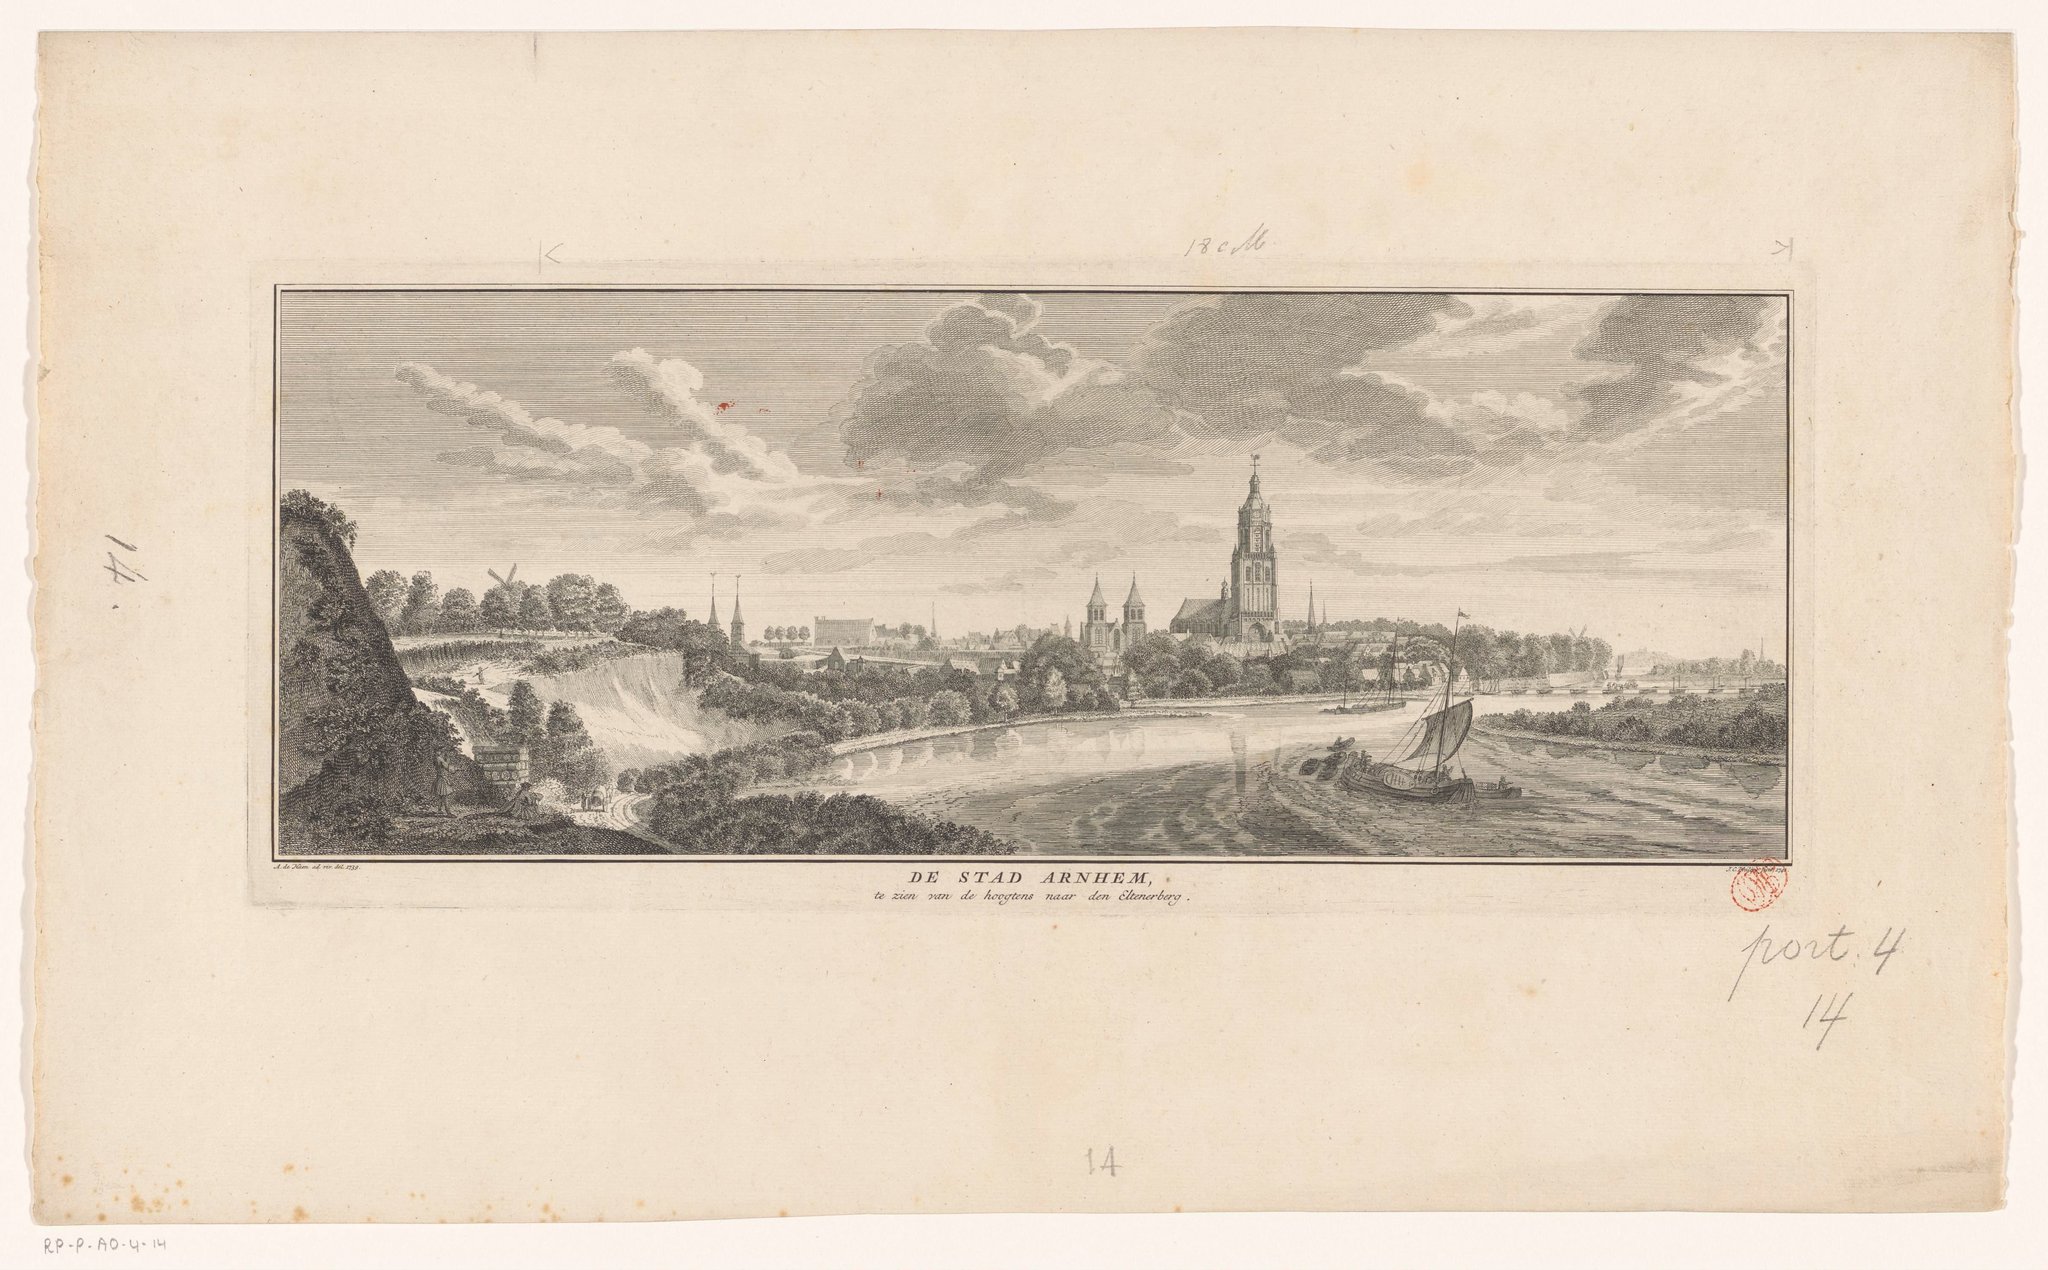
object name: print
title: De stad Arnhem, te zien van de hoogtens naar den Eltenerberg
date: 1741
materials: paper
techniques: engraving, etching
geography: amsterdam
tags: prospect of city, town panorama, silhouette of city, arnhem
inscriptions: collector's mark: Lugt 195, collector's mark: Lugt 2233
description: Prent ook gebruikt in: Wagenaar, Jan. Tegenwoordige staat der Vereenigde Nederlanden, derde deel. Vervattende de beschryving der provincie Gelderland (…) / Hedendaagsche historie of tegenwoordige staat van alle volkeren: XIIIde deel. Vervolgende de (…) en vervattende byzonderlyk die der provincie Gelderland (…). Amsterdam: Isaak Tirion, 1741.